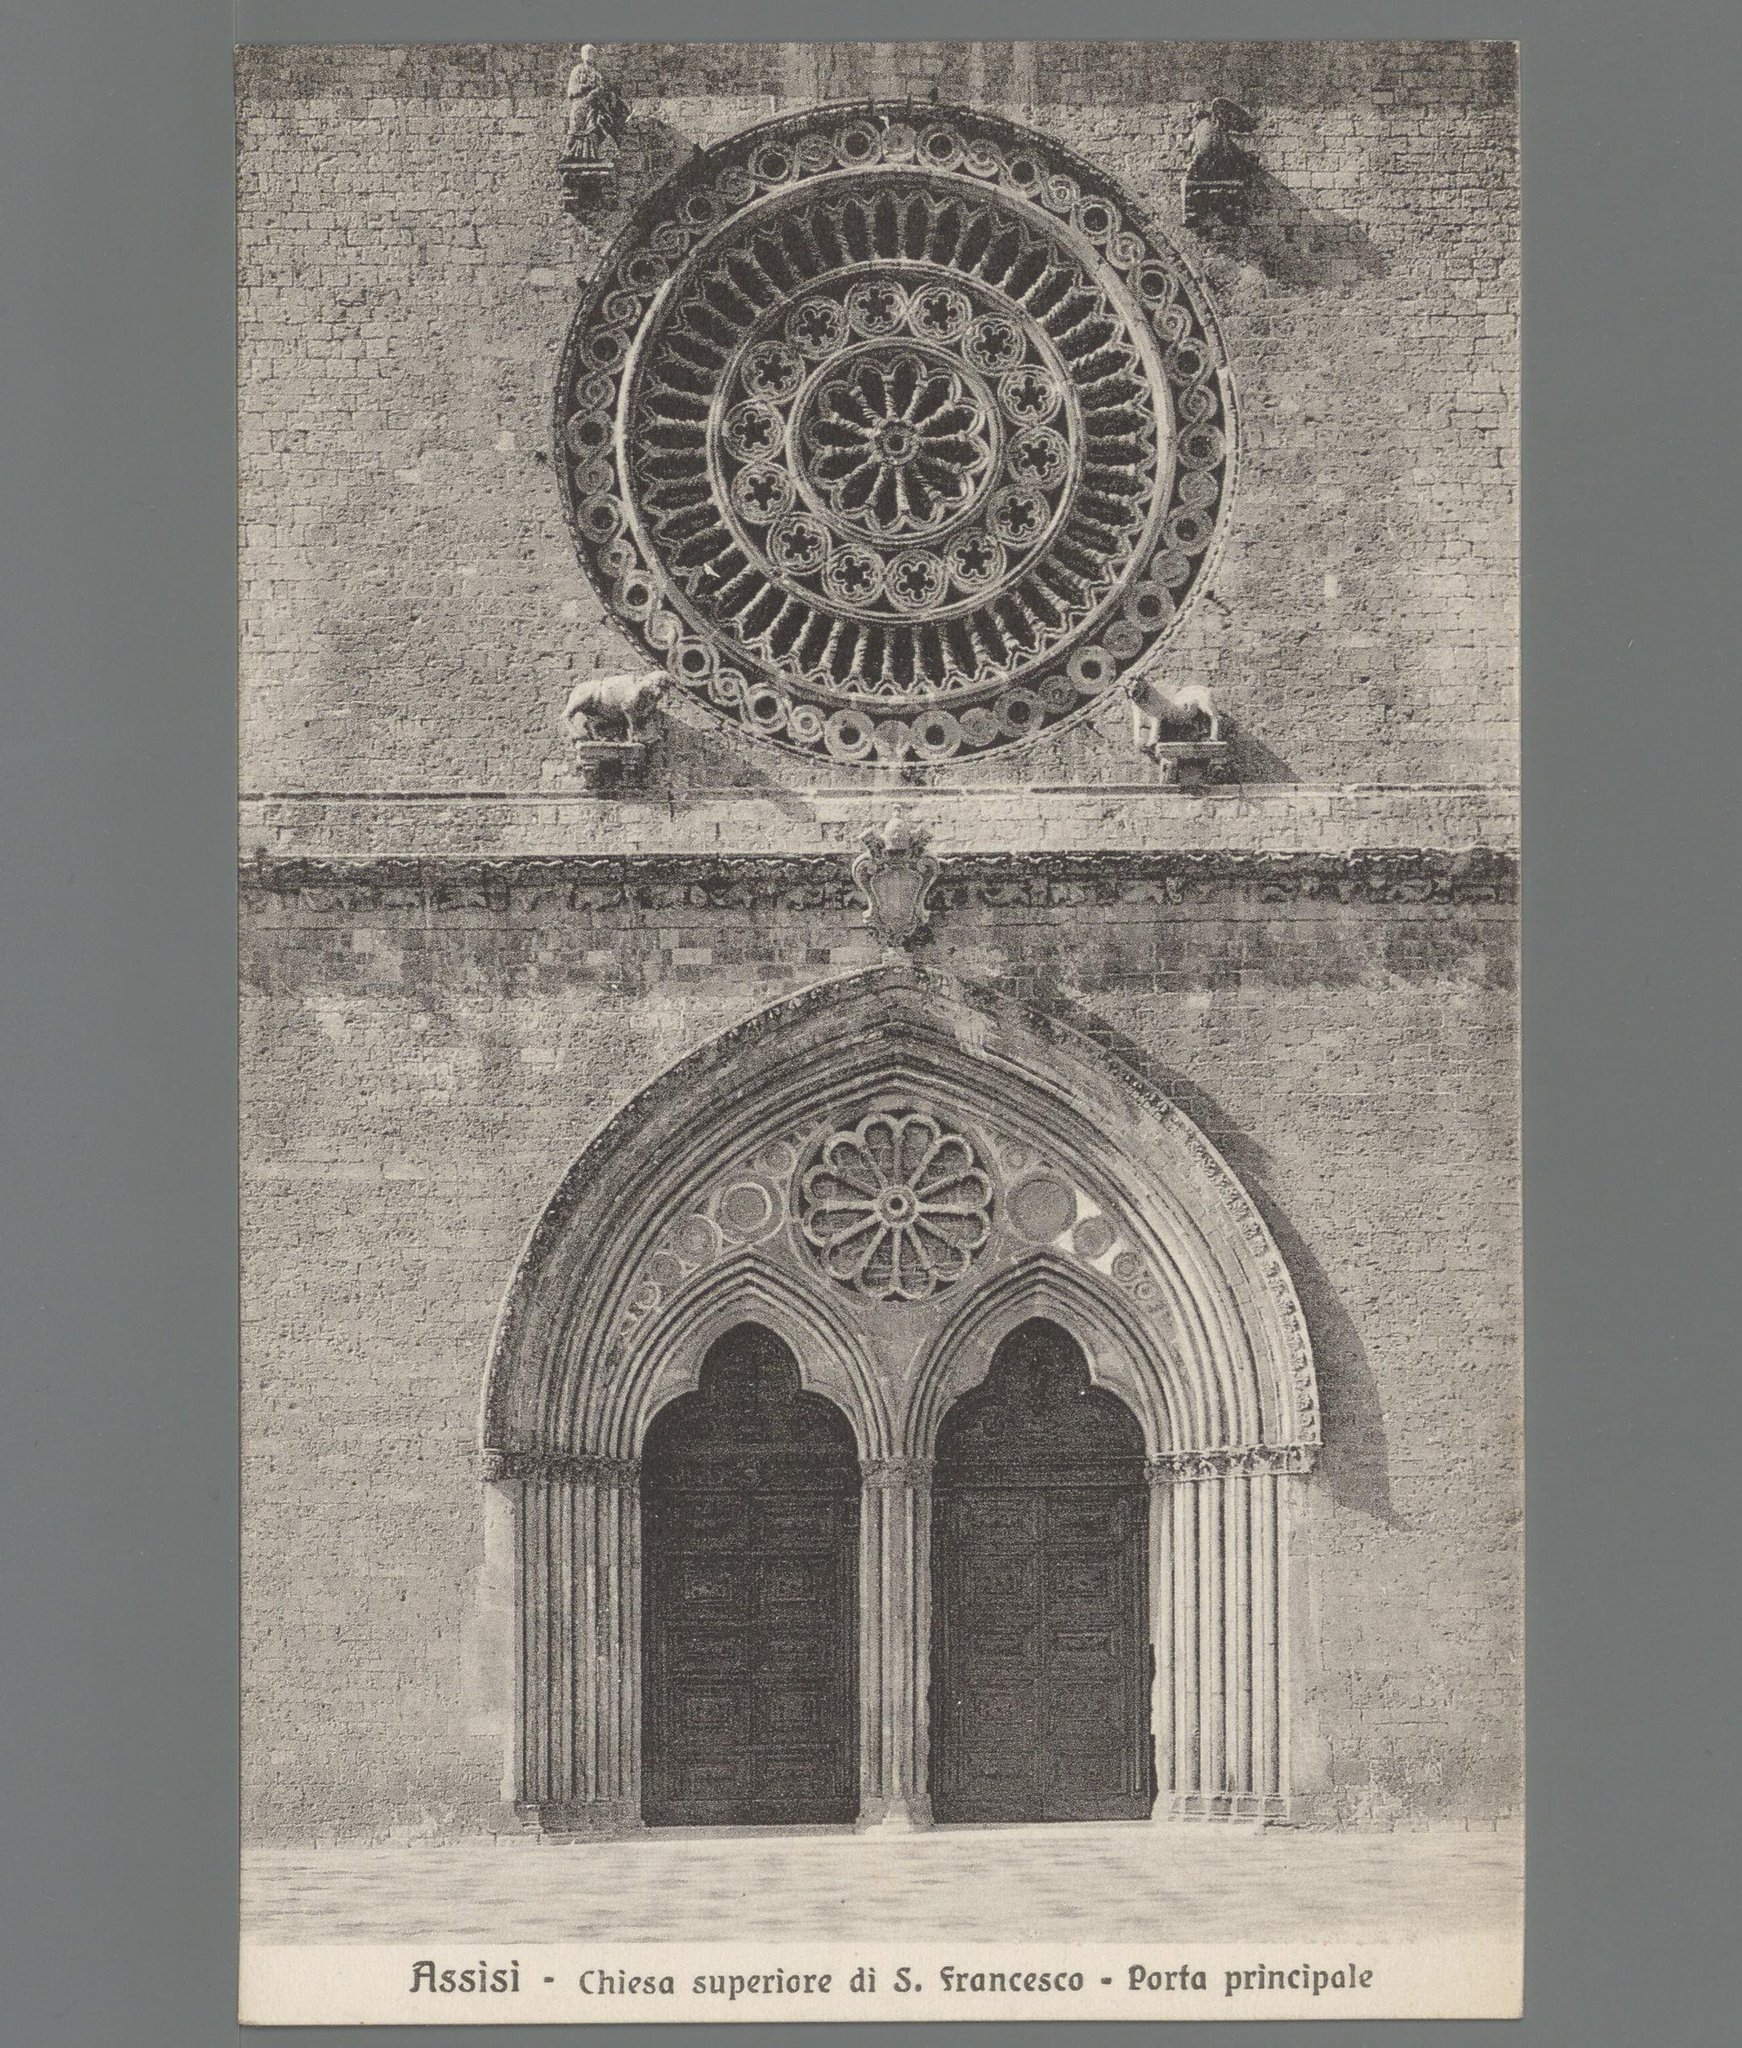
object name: photomechanical print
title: Assisi. Chiesa superiore di S. Francesco. Porta principale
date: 1906-1930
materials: cardboard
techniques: photograph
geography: assisi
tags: parts of church exterior and annexes: portal